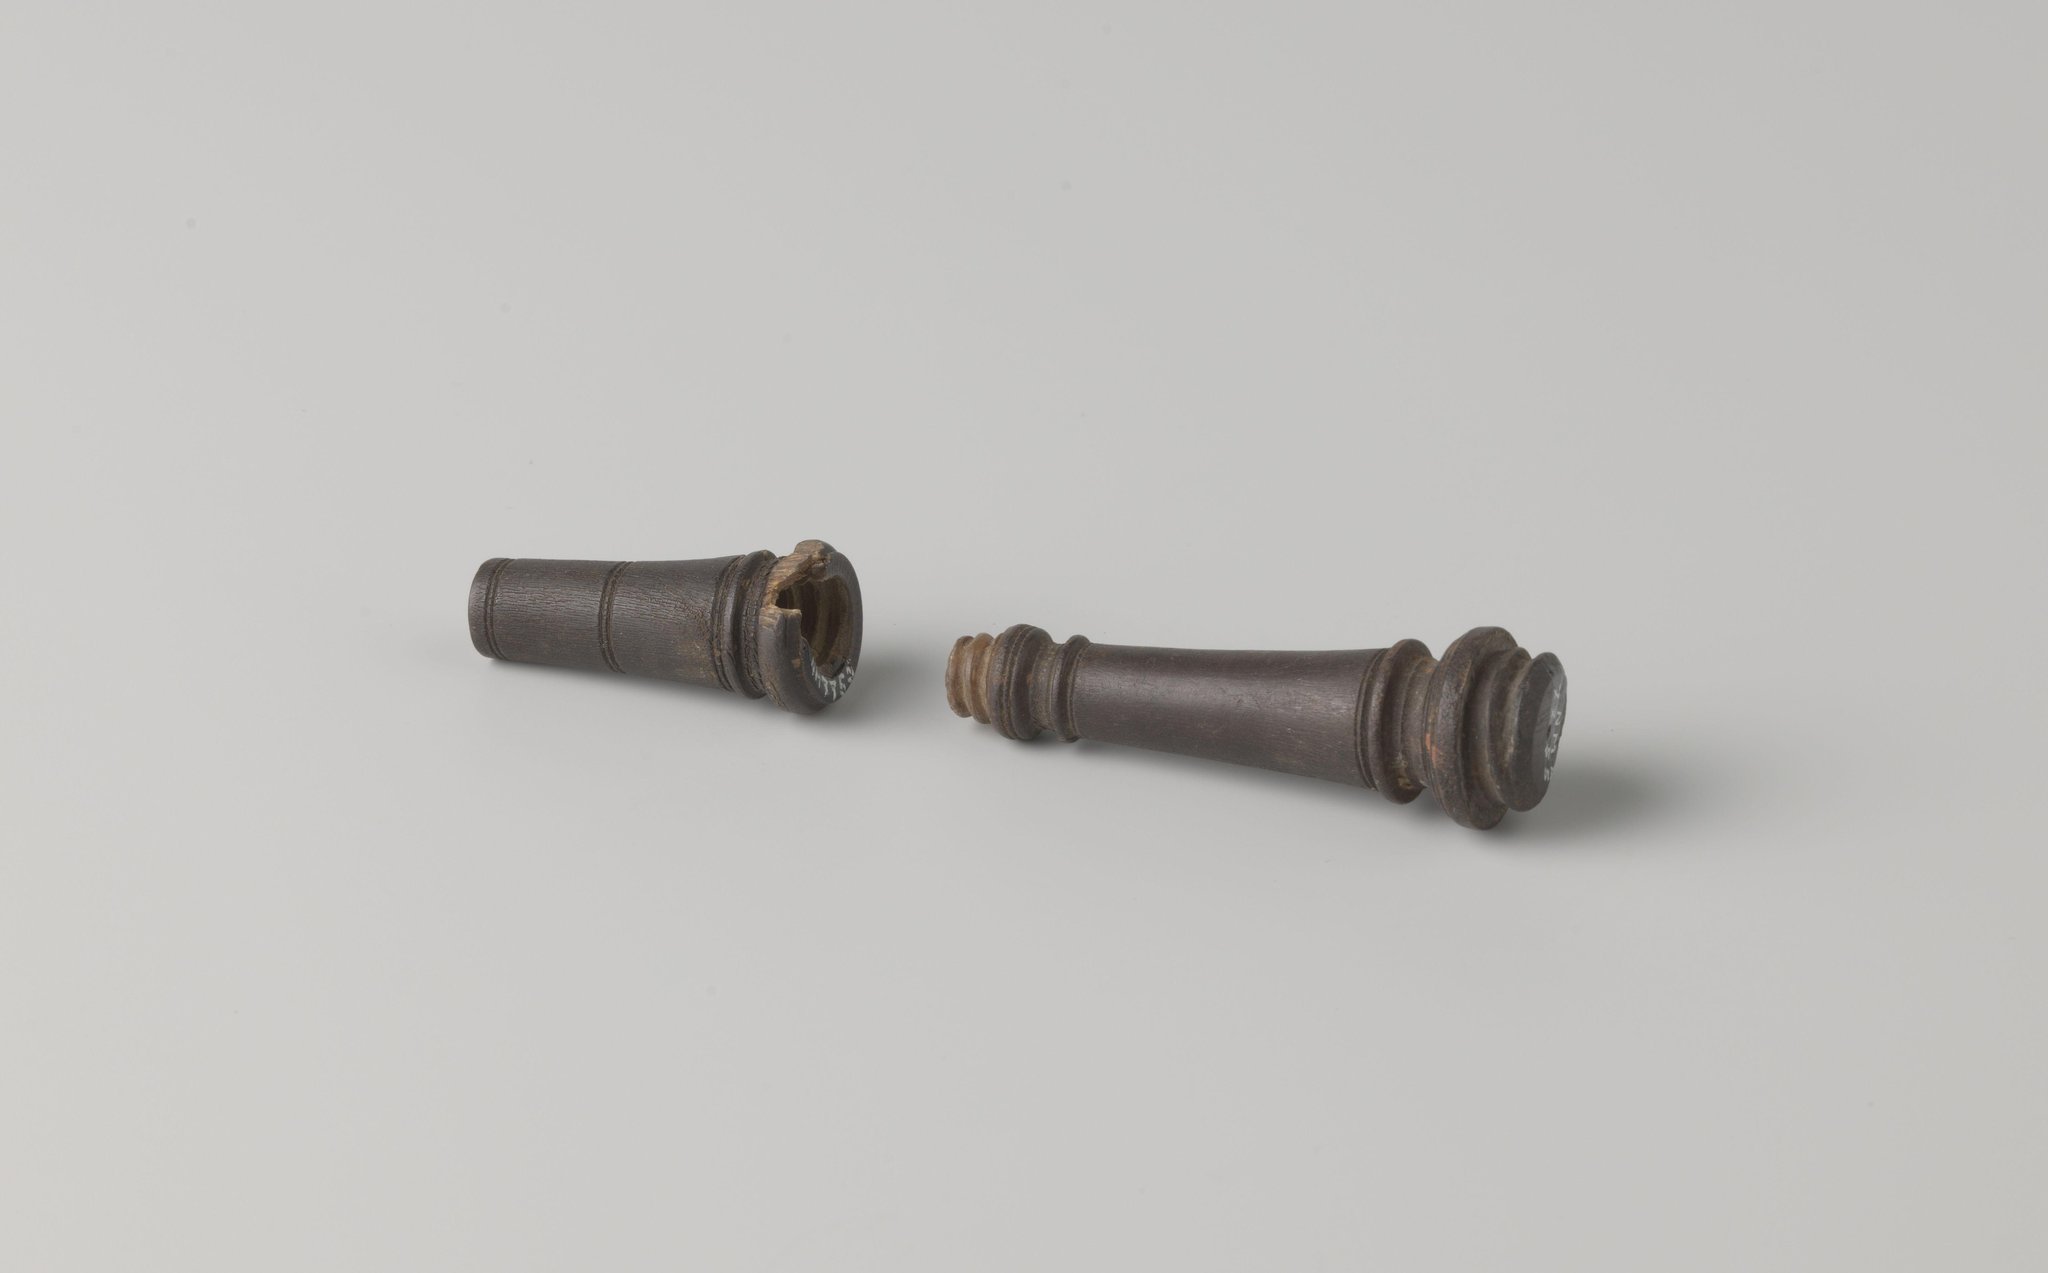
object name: zegelstempel, lakstempel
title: Zegelstempel met aan elkaar geschroefd handvat en een stempelvlak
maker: Anonymous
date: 1590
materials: bone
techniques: turning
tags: willem barendsz., amsterdam, jacob van heemskerck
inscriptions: inscription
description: Zegelstempel samengesteld uit een handvat en een stempelvlak die aan elkaar geschroefd kunnen worden. Het handvat is hol en heeft aan onderzijde een schroefdraad. De zegelstempel heeft waarschijnlijk toebehoord aan Claes Andrieszoon Goutijk, bemanningslid.